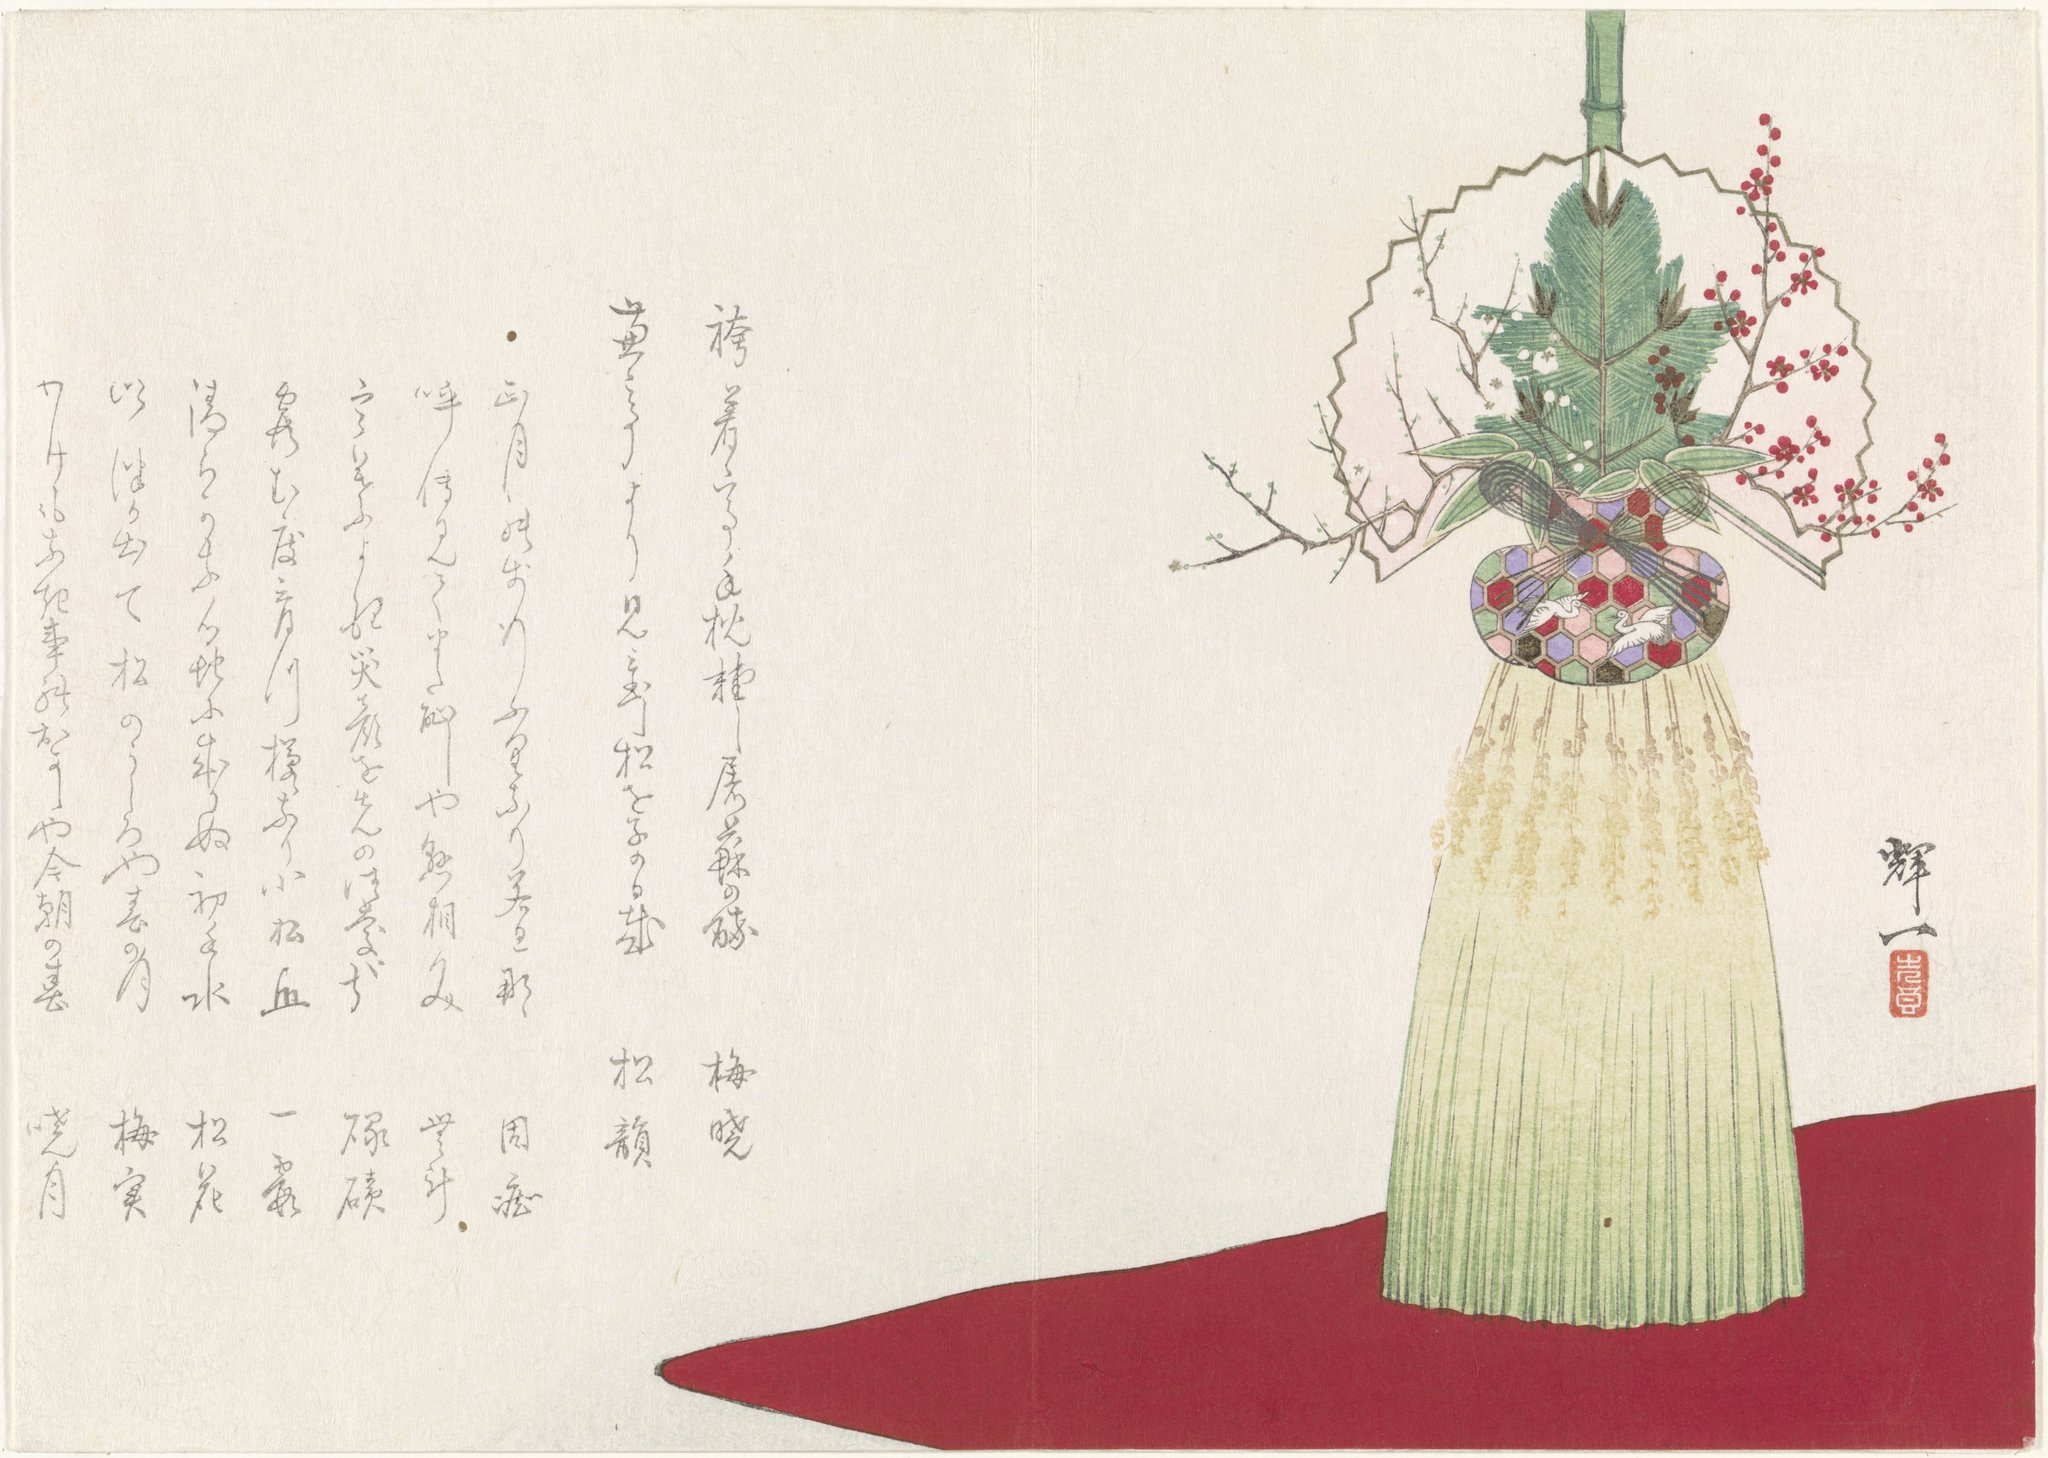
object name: print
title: Altaar voor het nieuwe jaar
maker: teruichi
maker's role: print maker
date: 1840-1880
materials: paper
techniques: blind stamped, woodcut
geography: japan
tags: altar ~ non-christian religions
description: Een surimono is een luxe uitgevoerde prent waarop beeld met één of meerdere gedichten gecombineerd is. Bij het drukken van een surimono werd vaak gebruik gemaakt van dikker papier, blinddruk en metaal pigmenten, zoals koper- en zilverpoeder. De prenten werden vaak in opdracht van dichters gemaakt en als exclusief geschenk aan vrienden en relaties gegeven.